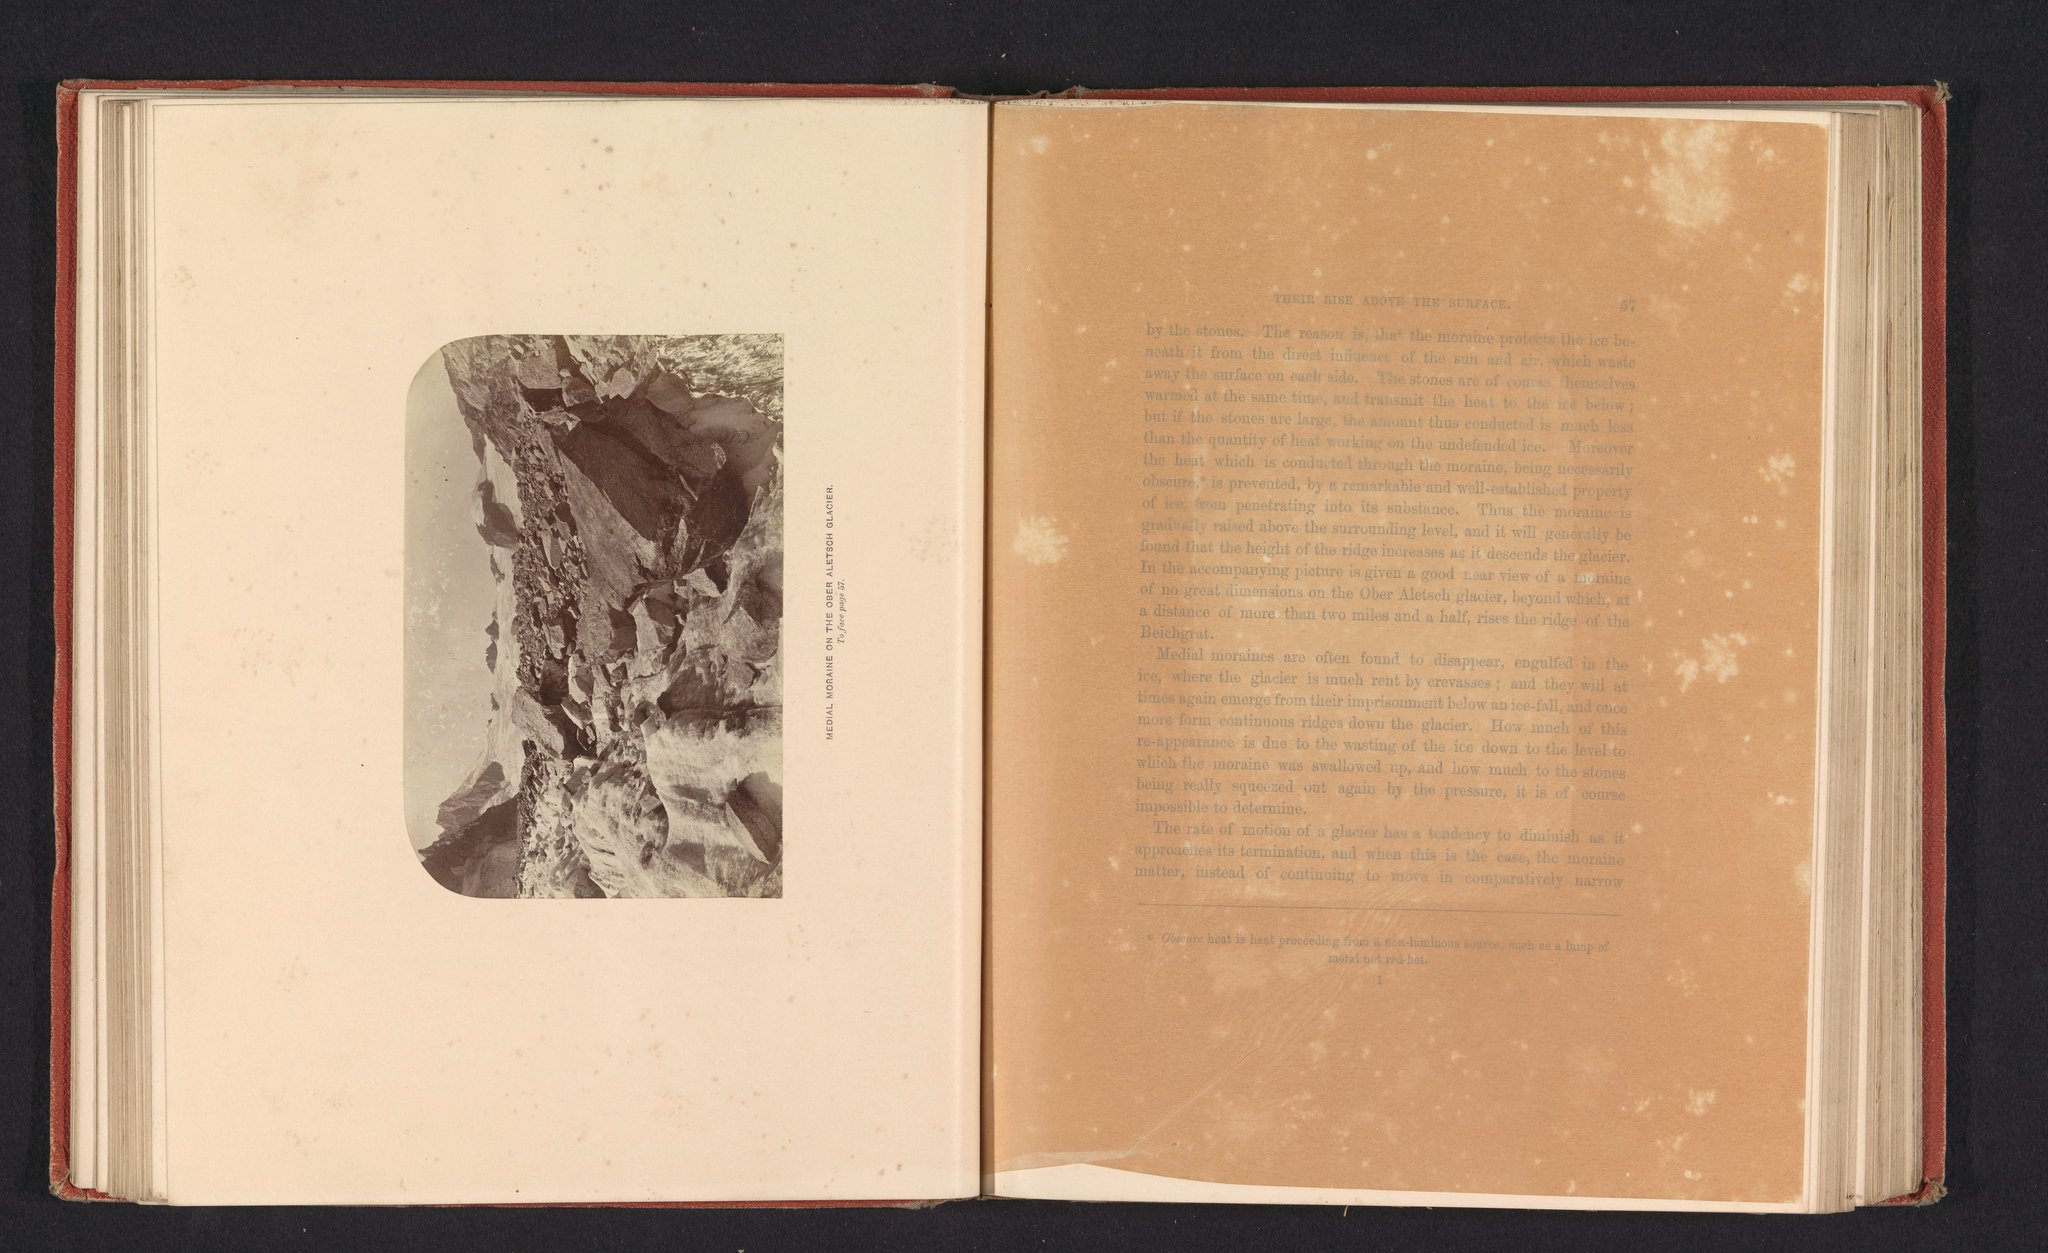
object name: page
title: Medial moraine on the Ober Aletsch glacier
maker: ernest edwards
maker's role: fotograaf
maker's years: 1837-1903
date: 1850-1866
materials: photographic support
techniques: albumen print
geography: bern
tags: glacier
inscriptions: inscription: ‘To face page 57.’